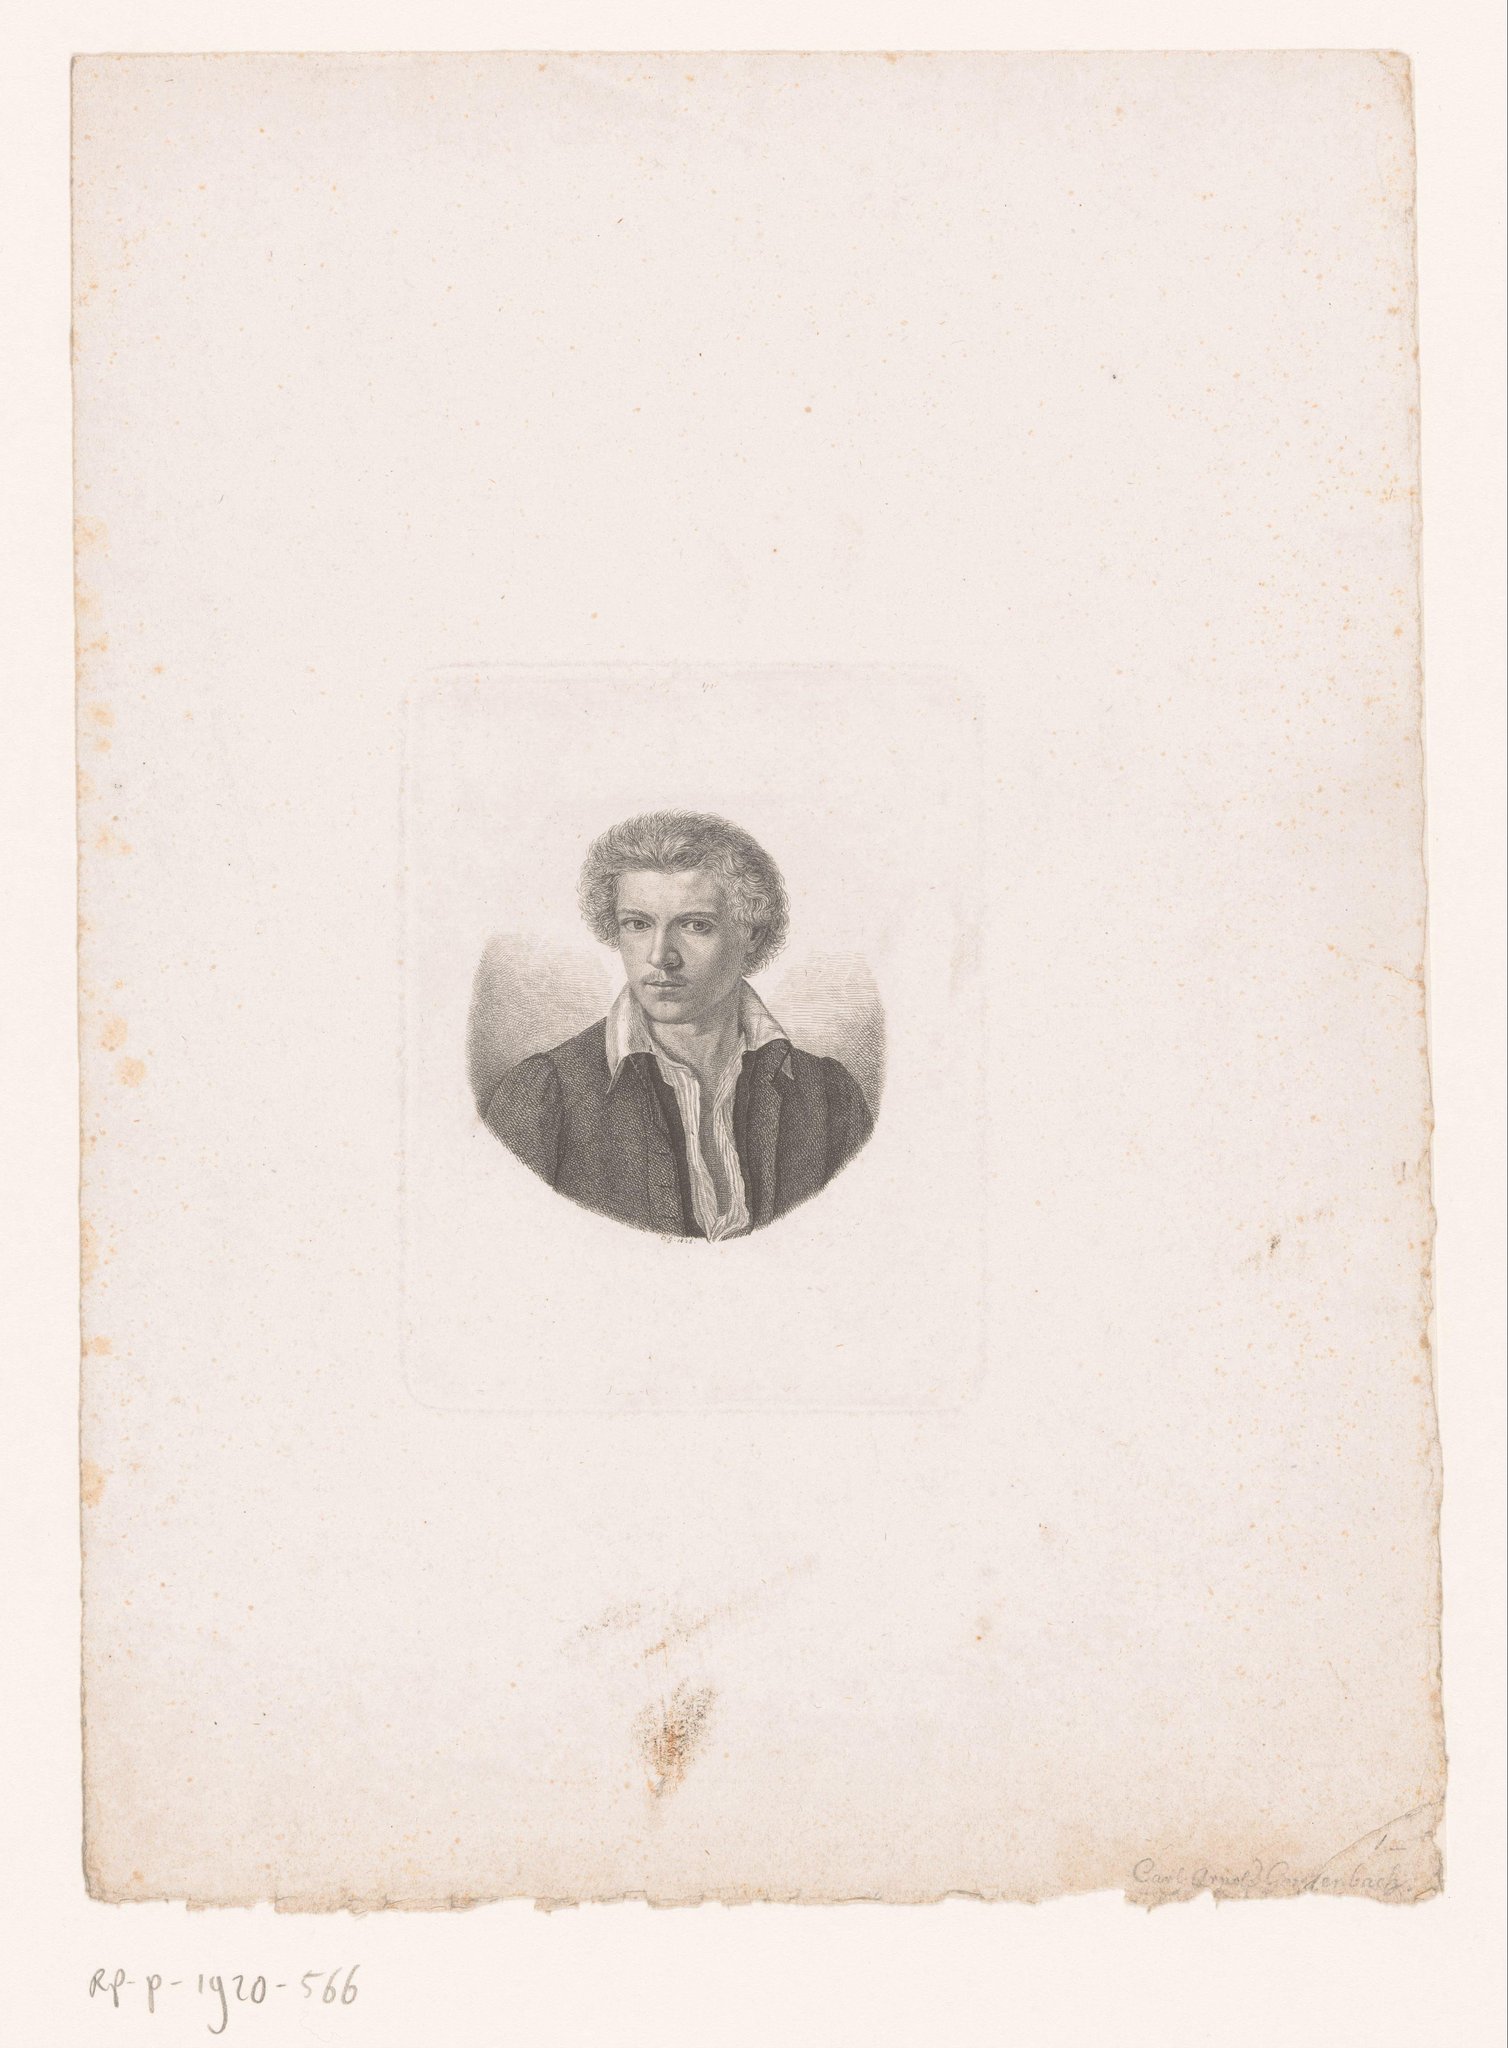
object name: print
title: Portret van een onbekende man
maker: monogrammist cg (engeland)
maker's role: print maker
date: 1825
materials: paper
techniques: etching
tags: historical persons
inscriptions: collector's mark: Lugt 2228